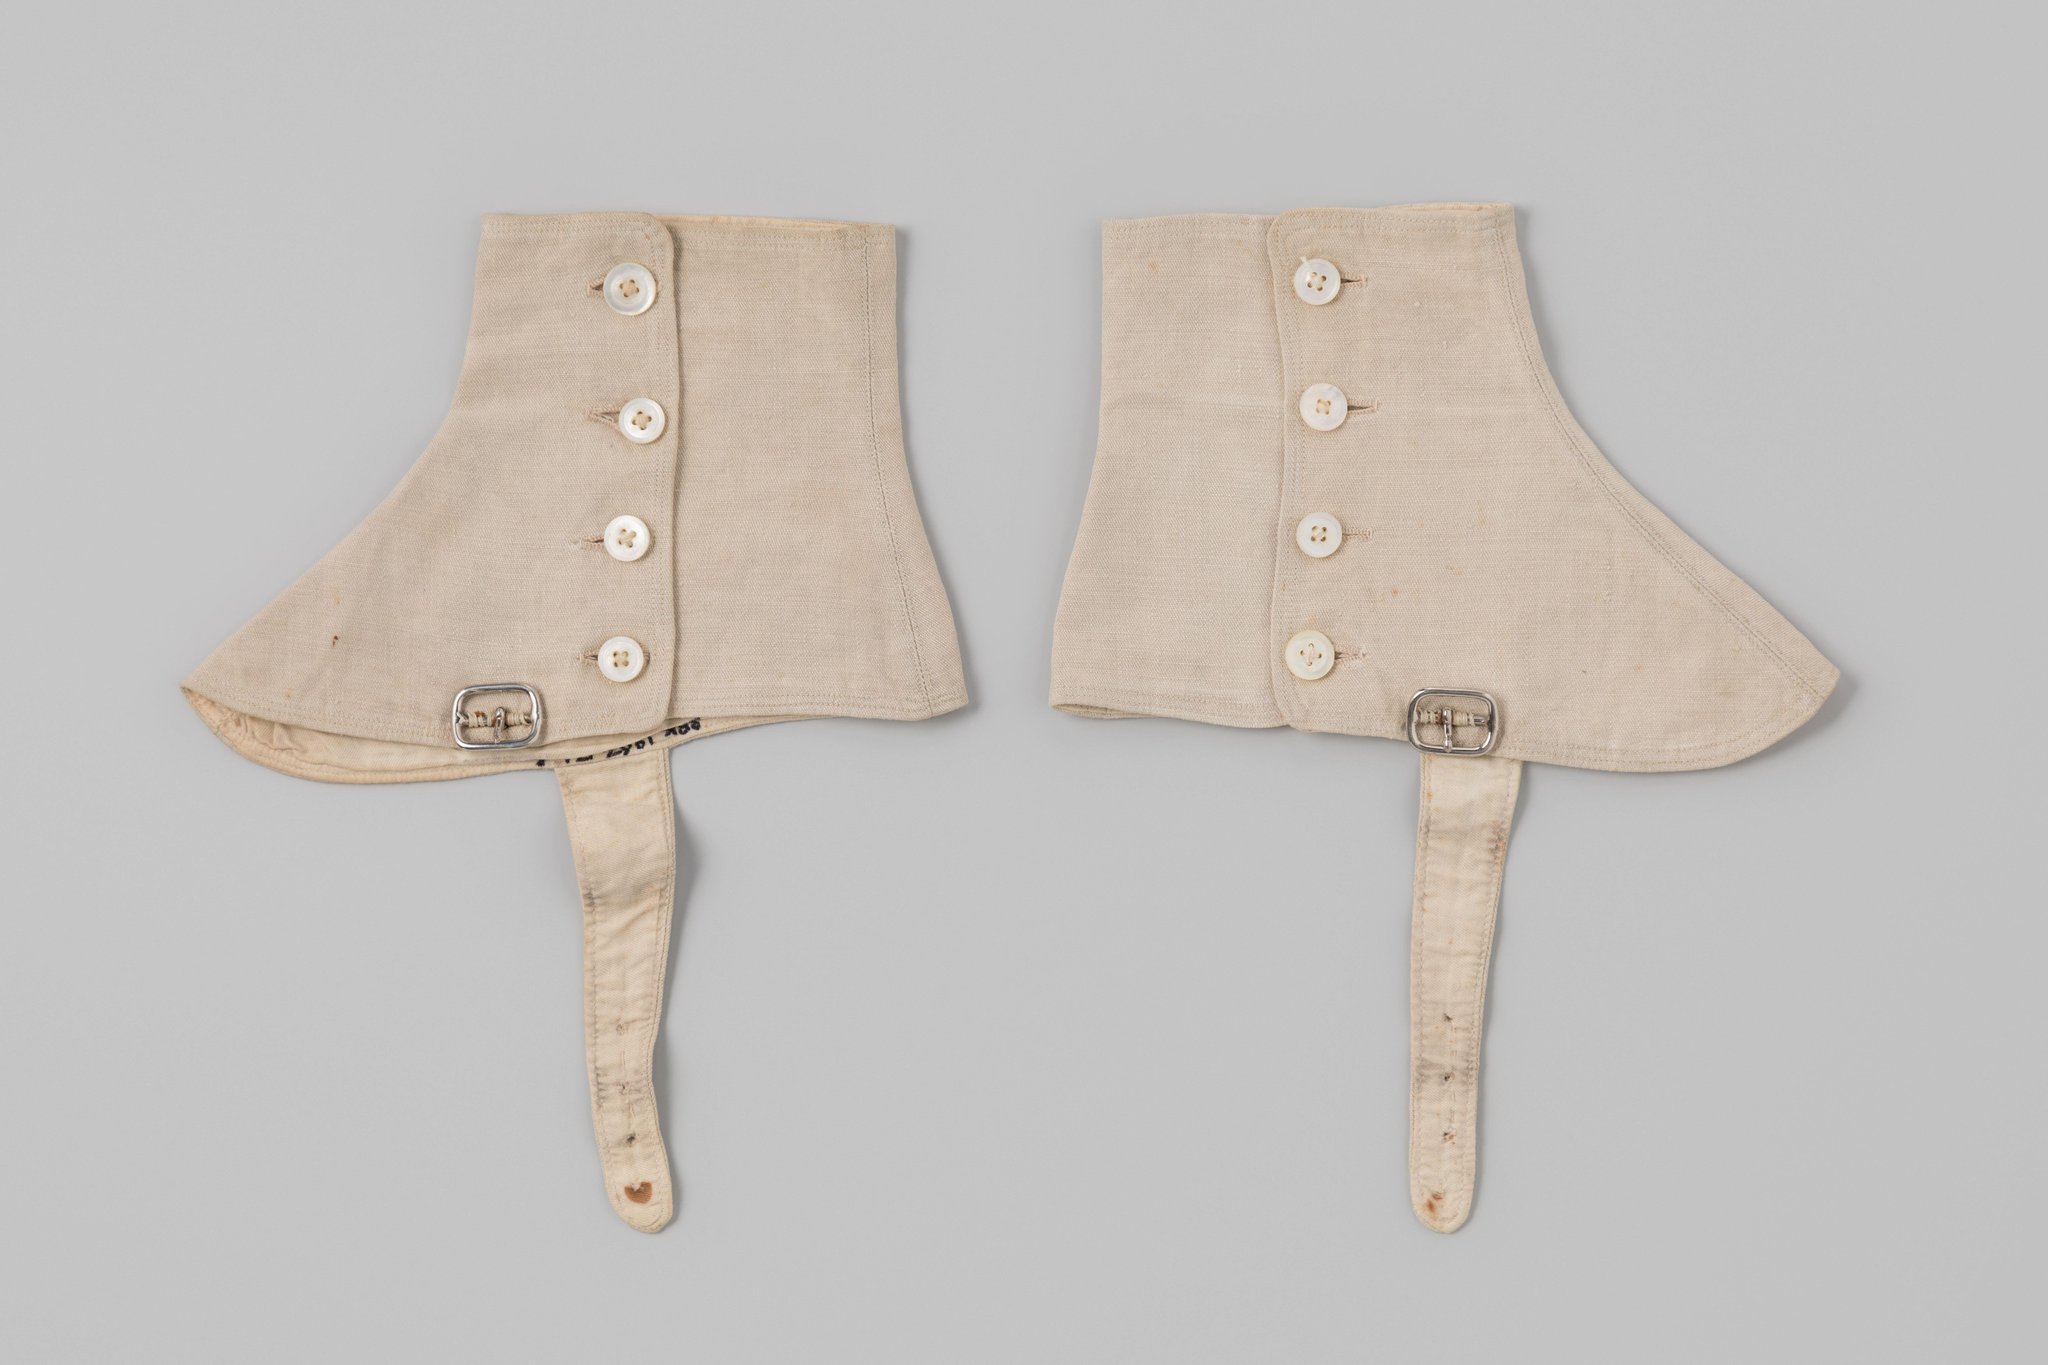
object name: clothing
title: Slobkous van ecrukleurig keperkatoen, waarop vier parelmoerkleurige knopen en een linnen riem met metalen gesp onder de voet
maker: Anonymous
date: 1900-1930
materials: cotton, metal, mother of pearl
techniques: weave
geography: netherlands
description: Slobkous van ecrukleurig keperkatoen, waarop vier parelmoerkleurige knopen en een linnen riem met metalen gesp onder de voet. Voering van ecrukleurig katoen